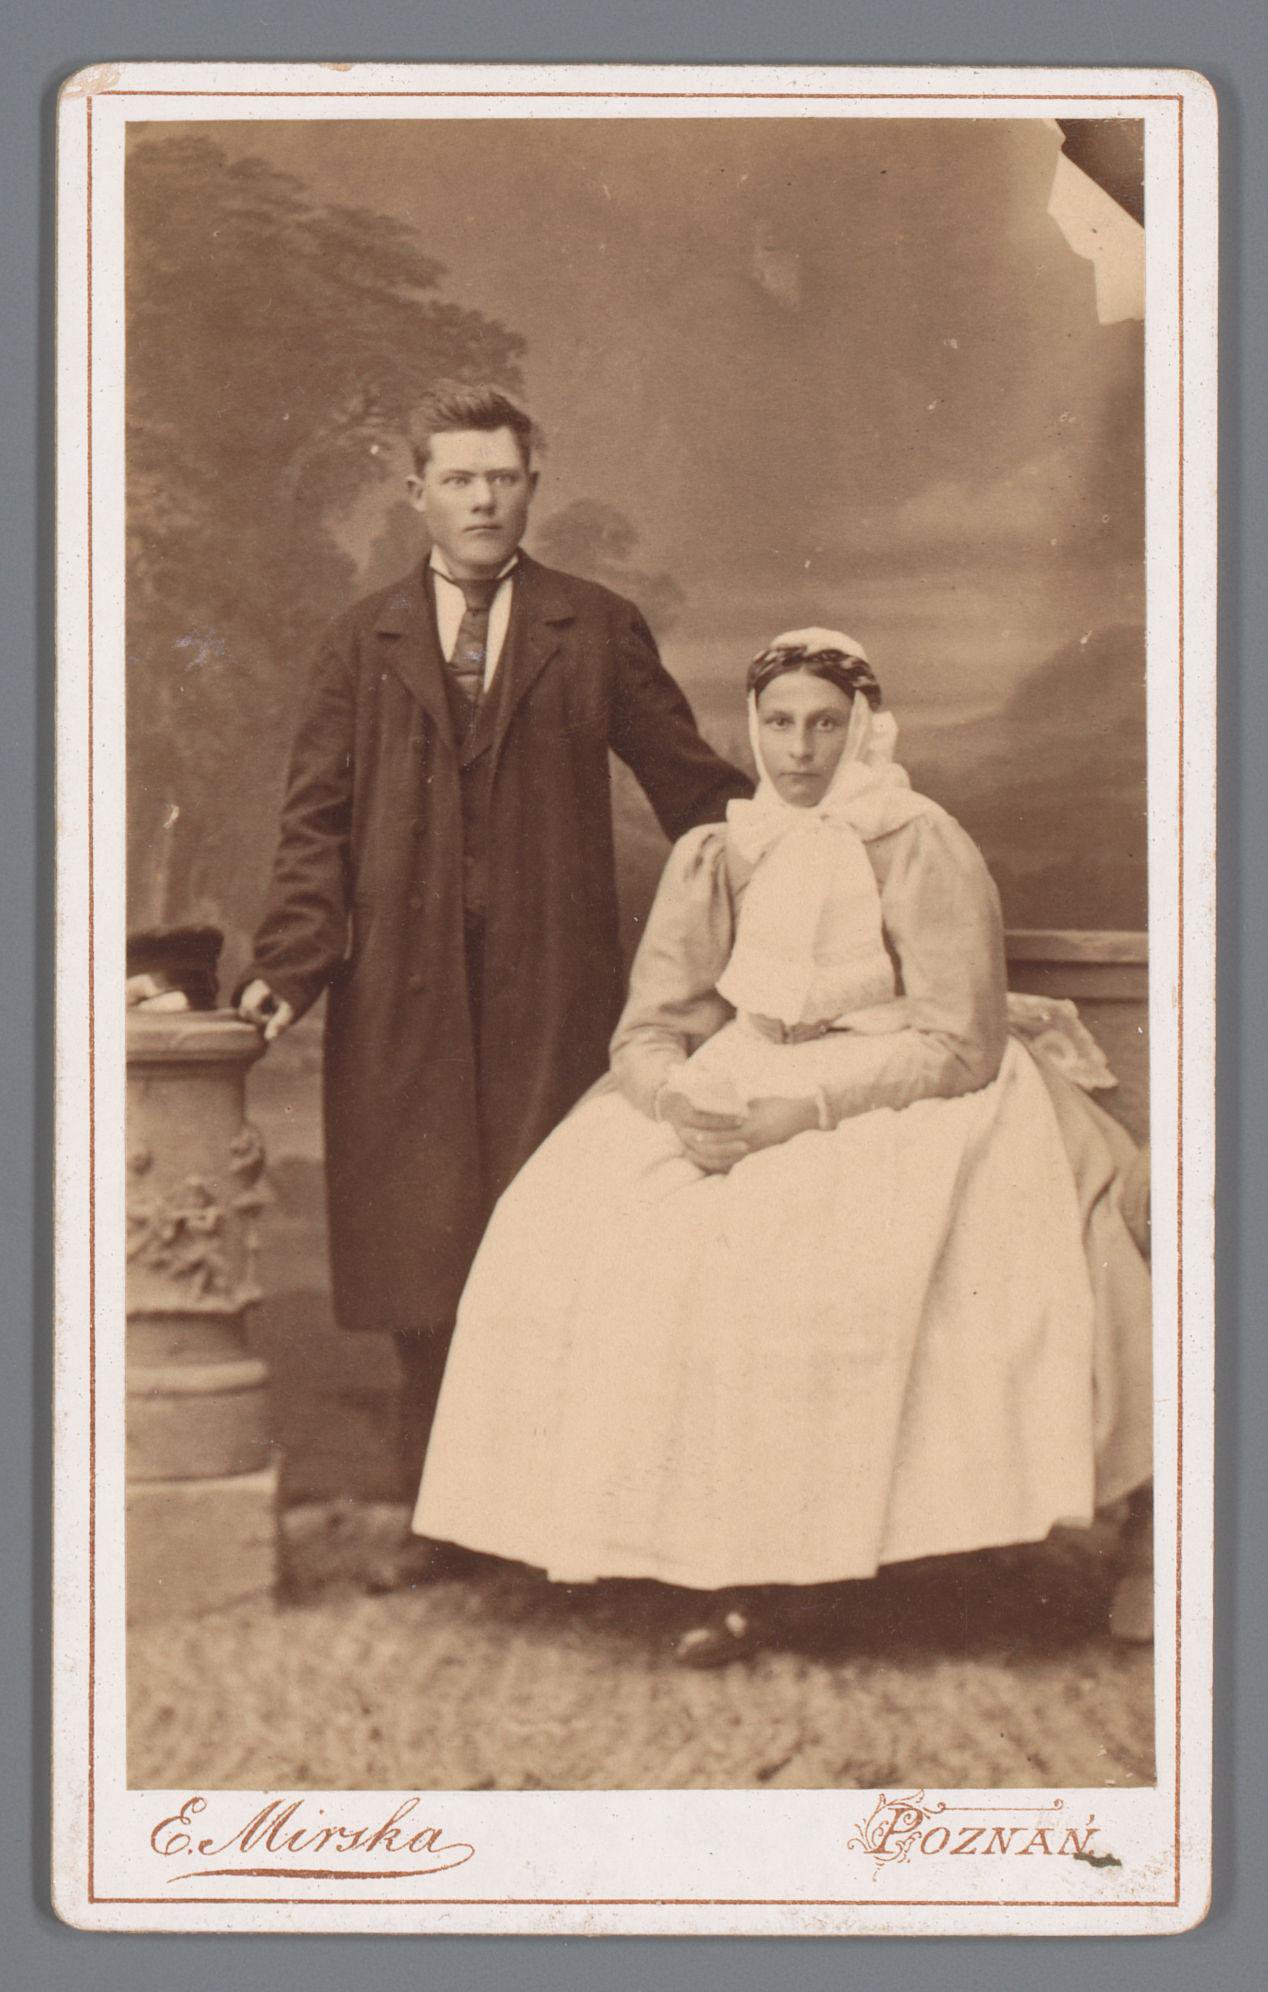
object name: carte de visite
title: Portret van een onbekende man en vrouw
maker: e. mirska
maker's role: fotograaf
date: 1875-1885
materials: cardboard, paper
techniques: albumen print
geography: poznan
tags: adult woman, adult man, anonymous historical person portrayed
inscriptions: inscription: ‘J. & N.’